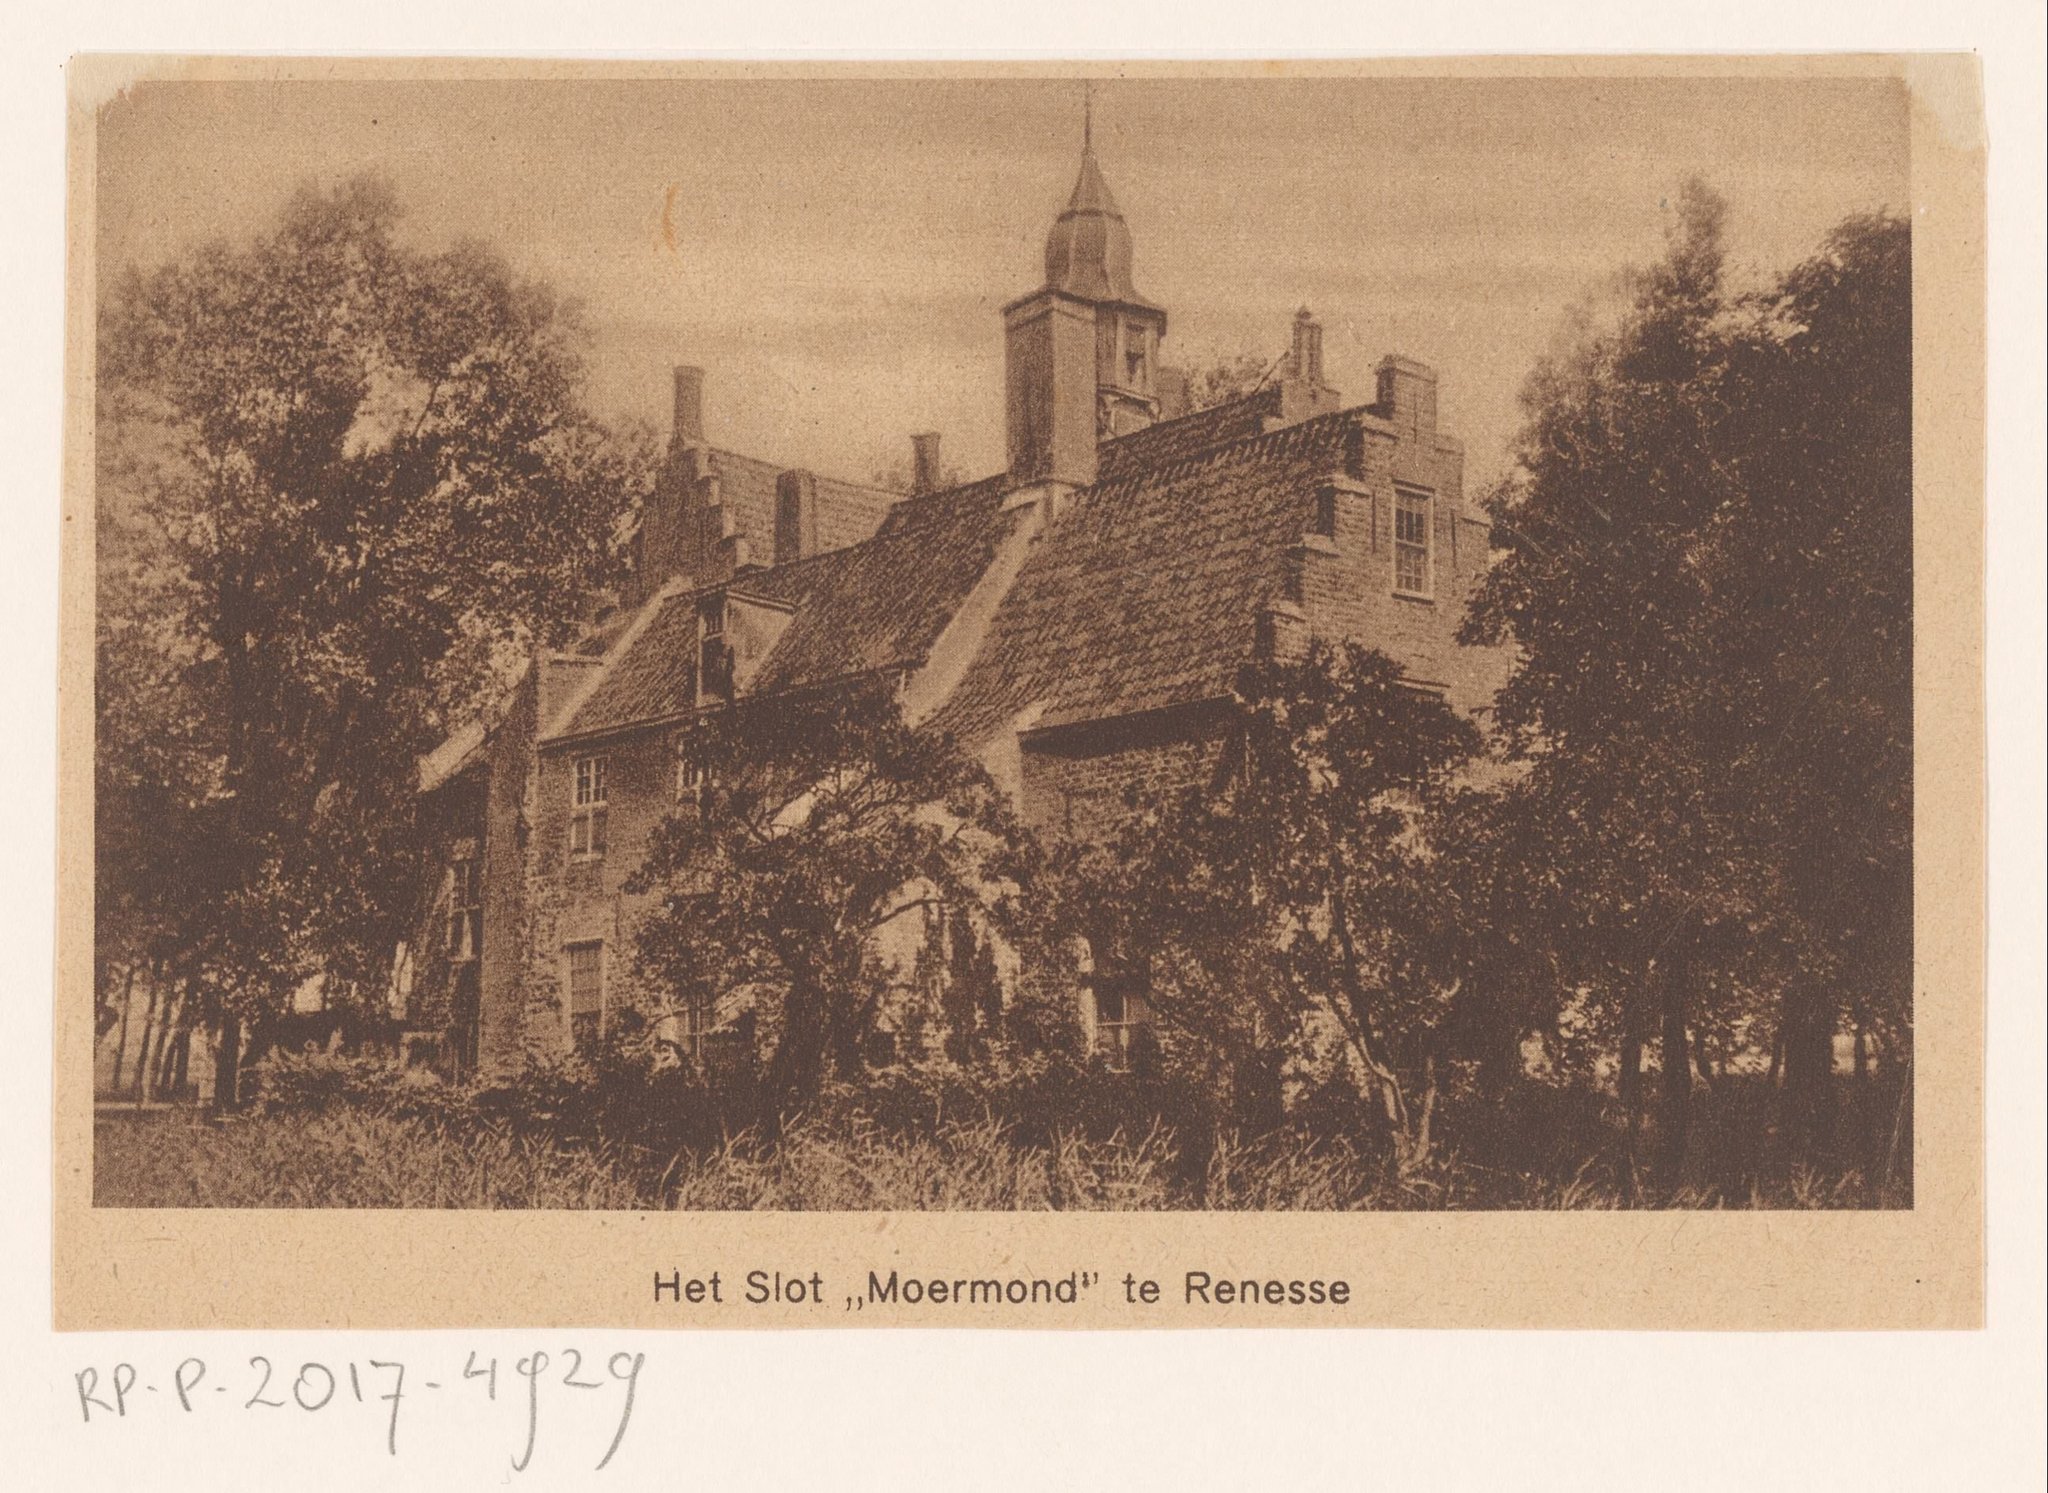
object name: photomechanical print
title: Gezicht op Slot Moermond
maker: Anonymous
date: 1913-1960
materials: paper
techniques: rotogravure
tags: castle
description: Gezicht op Slot Moermond te Renesse in Zeeland.